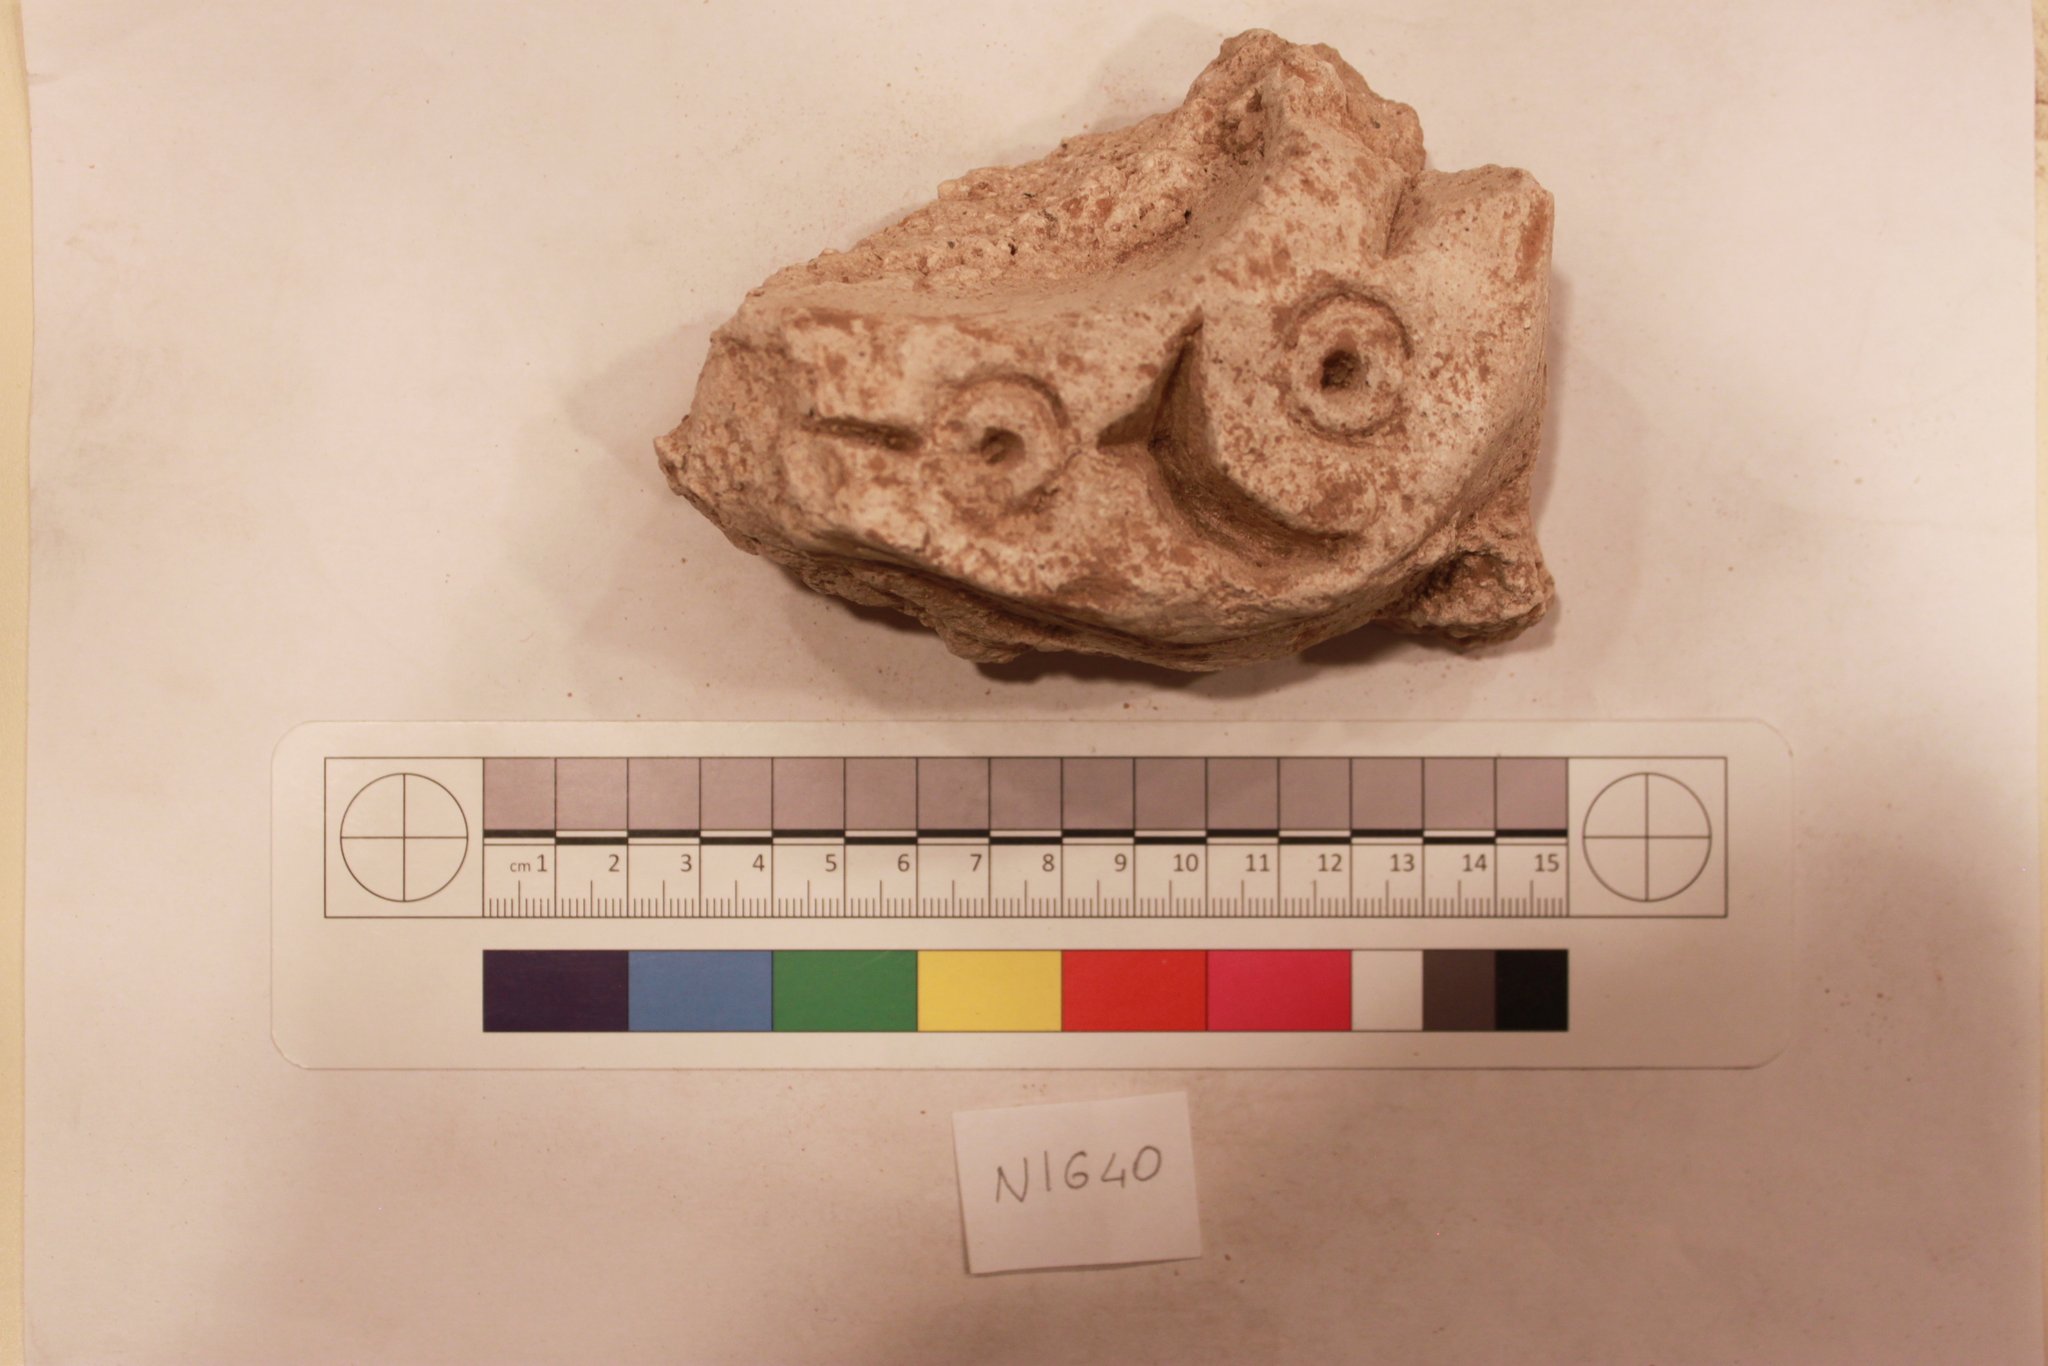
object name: fragment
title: Stucco Fragment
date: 701-1200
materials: plaster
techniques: carving, painting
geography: iran